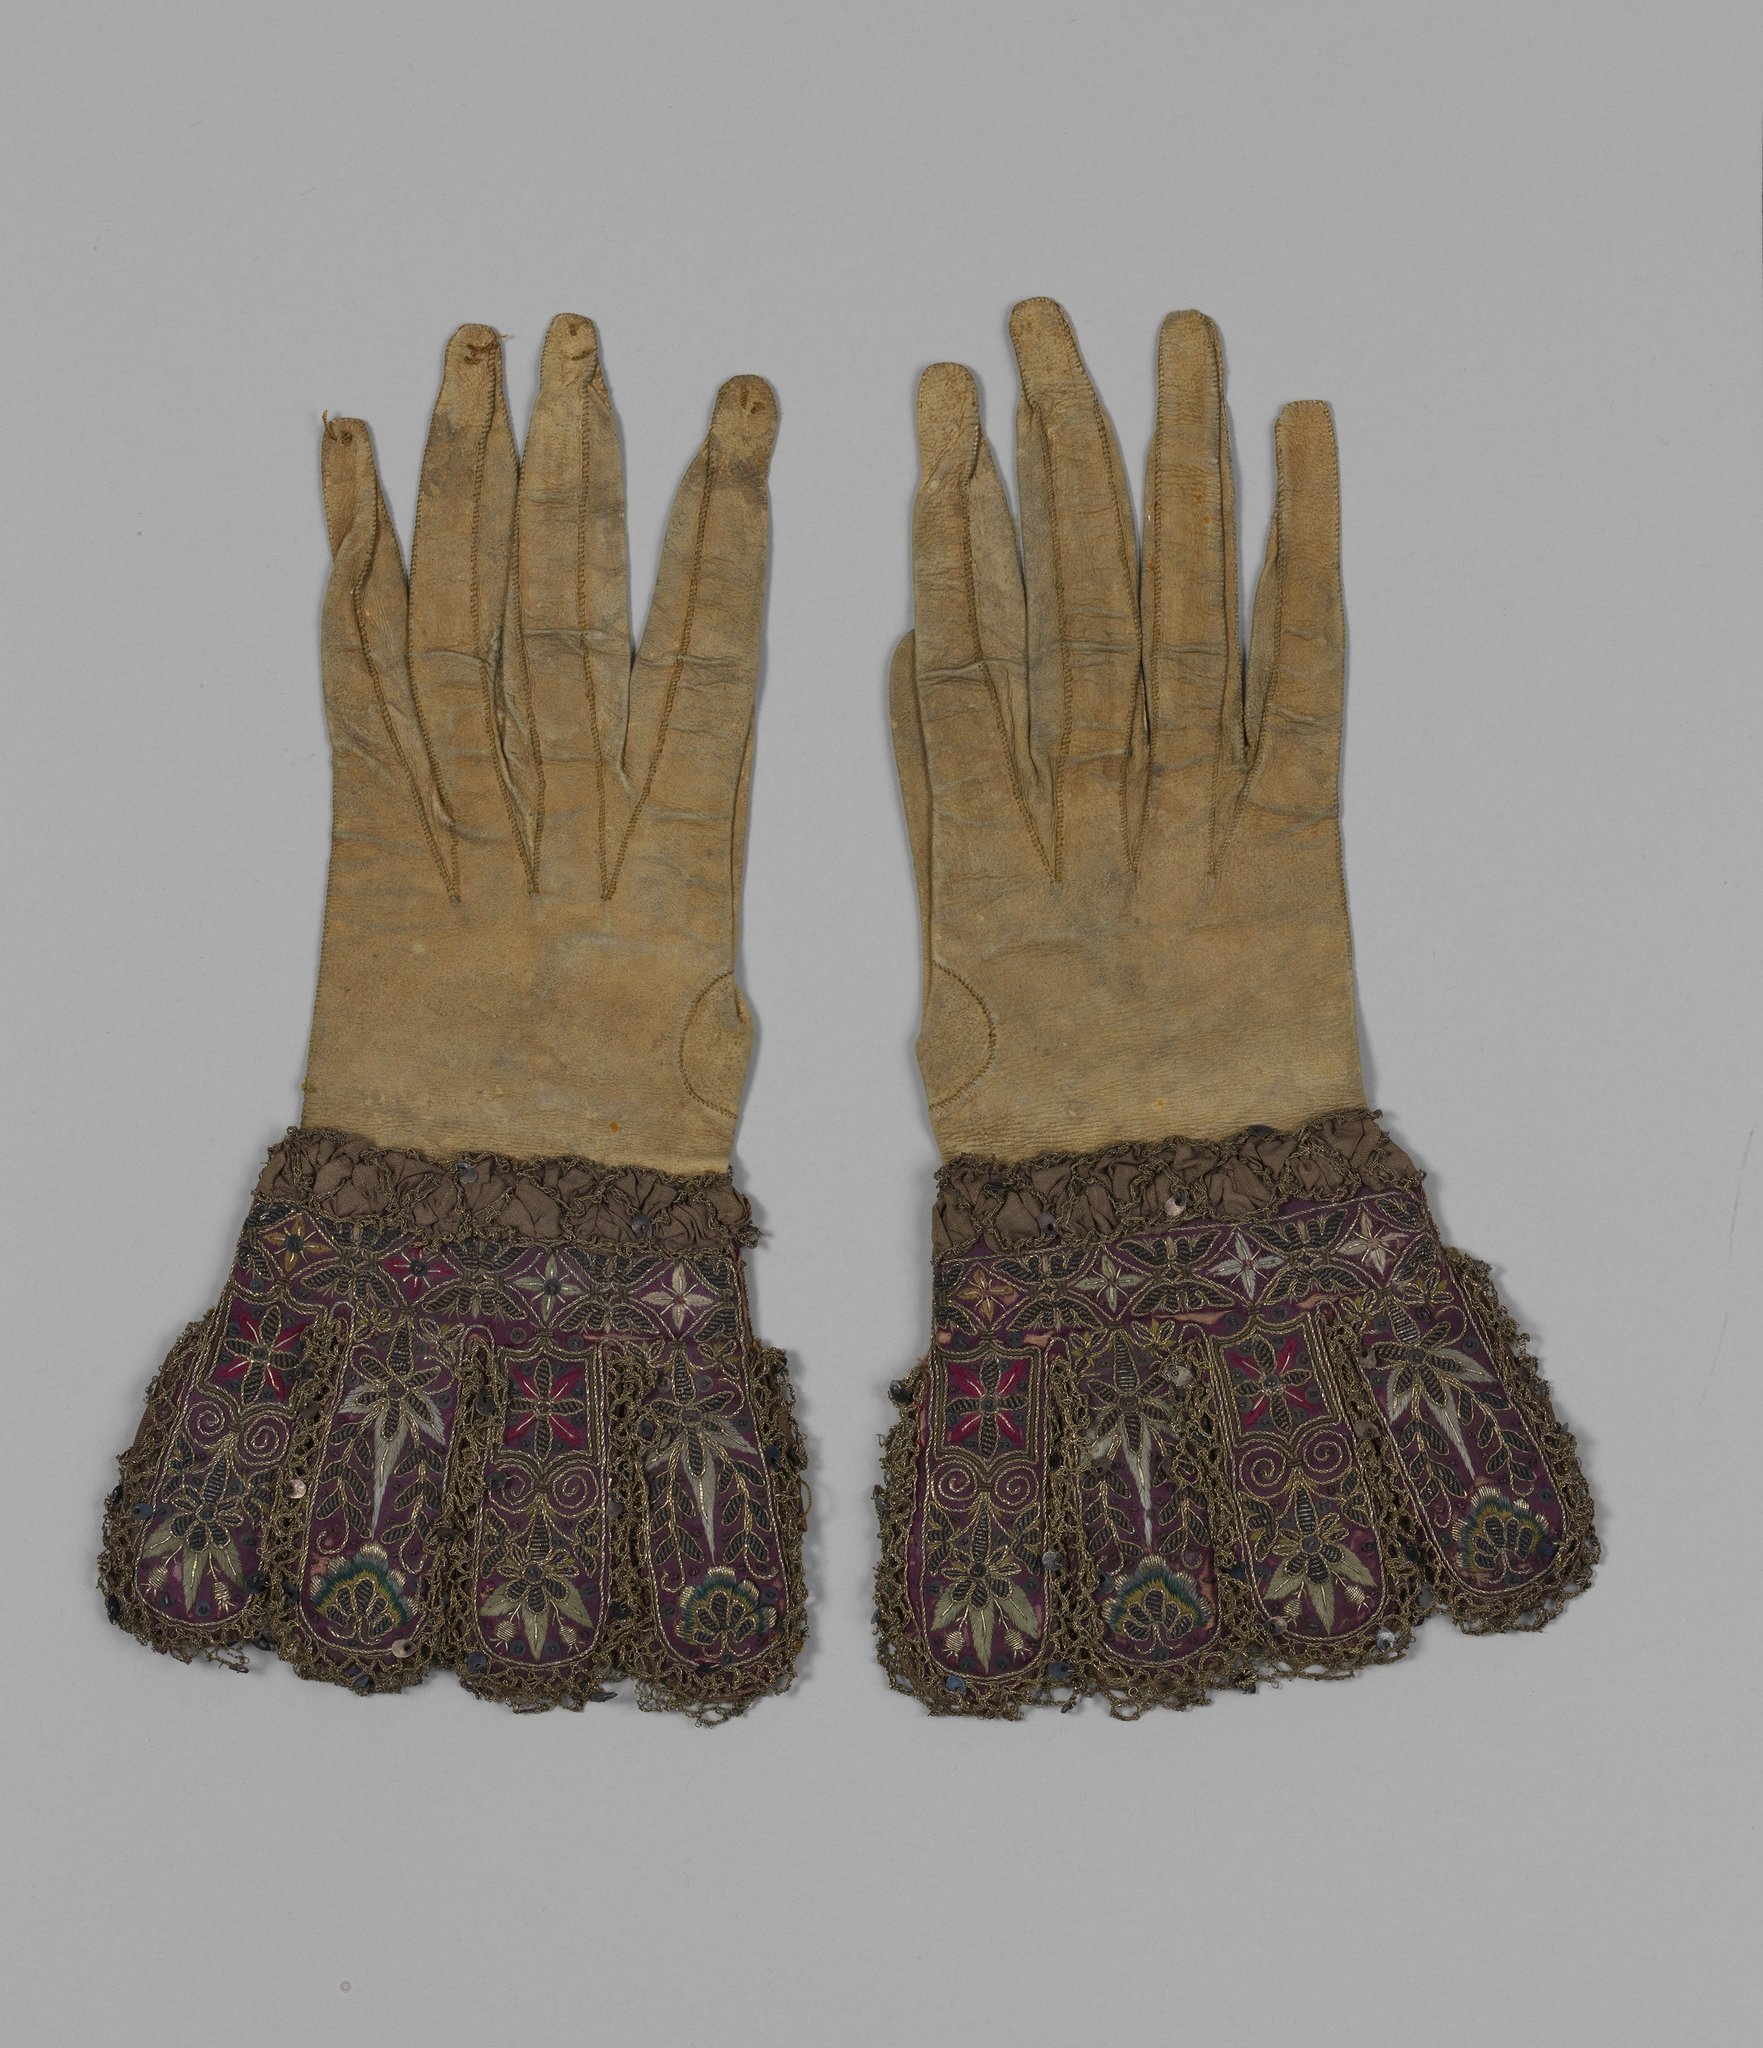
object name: glove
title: Pair of gloves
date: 1601-1650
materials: linen, metal thread, silk